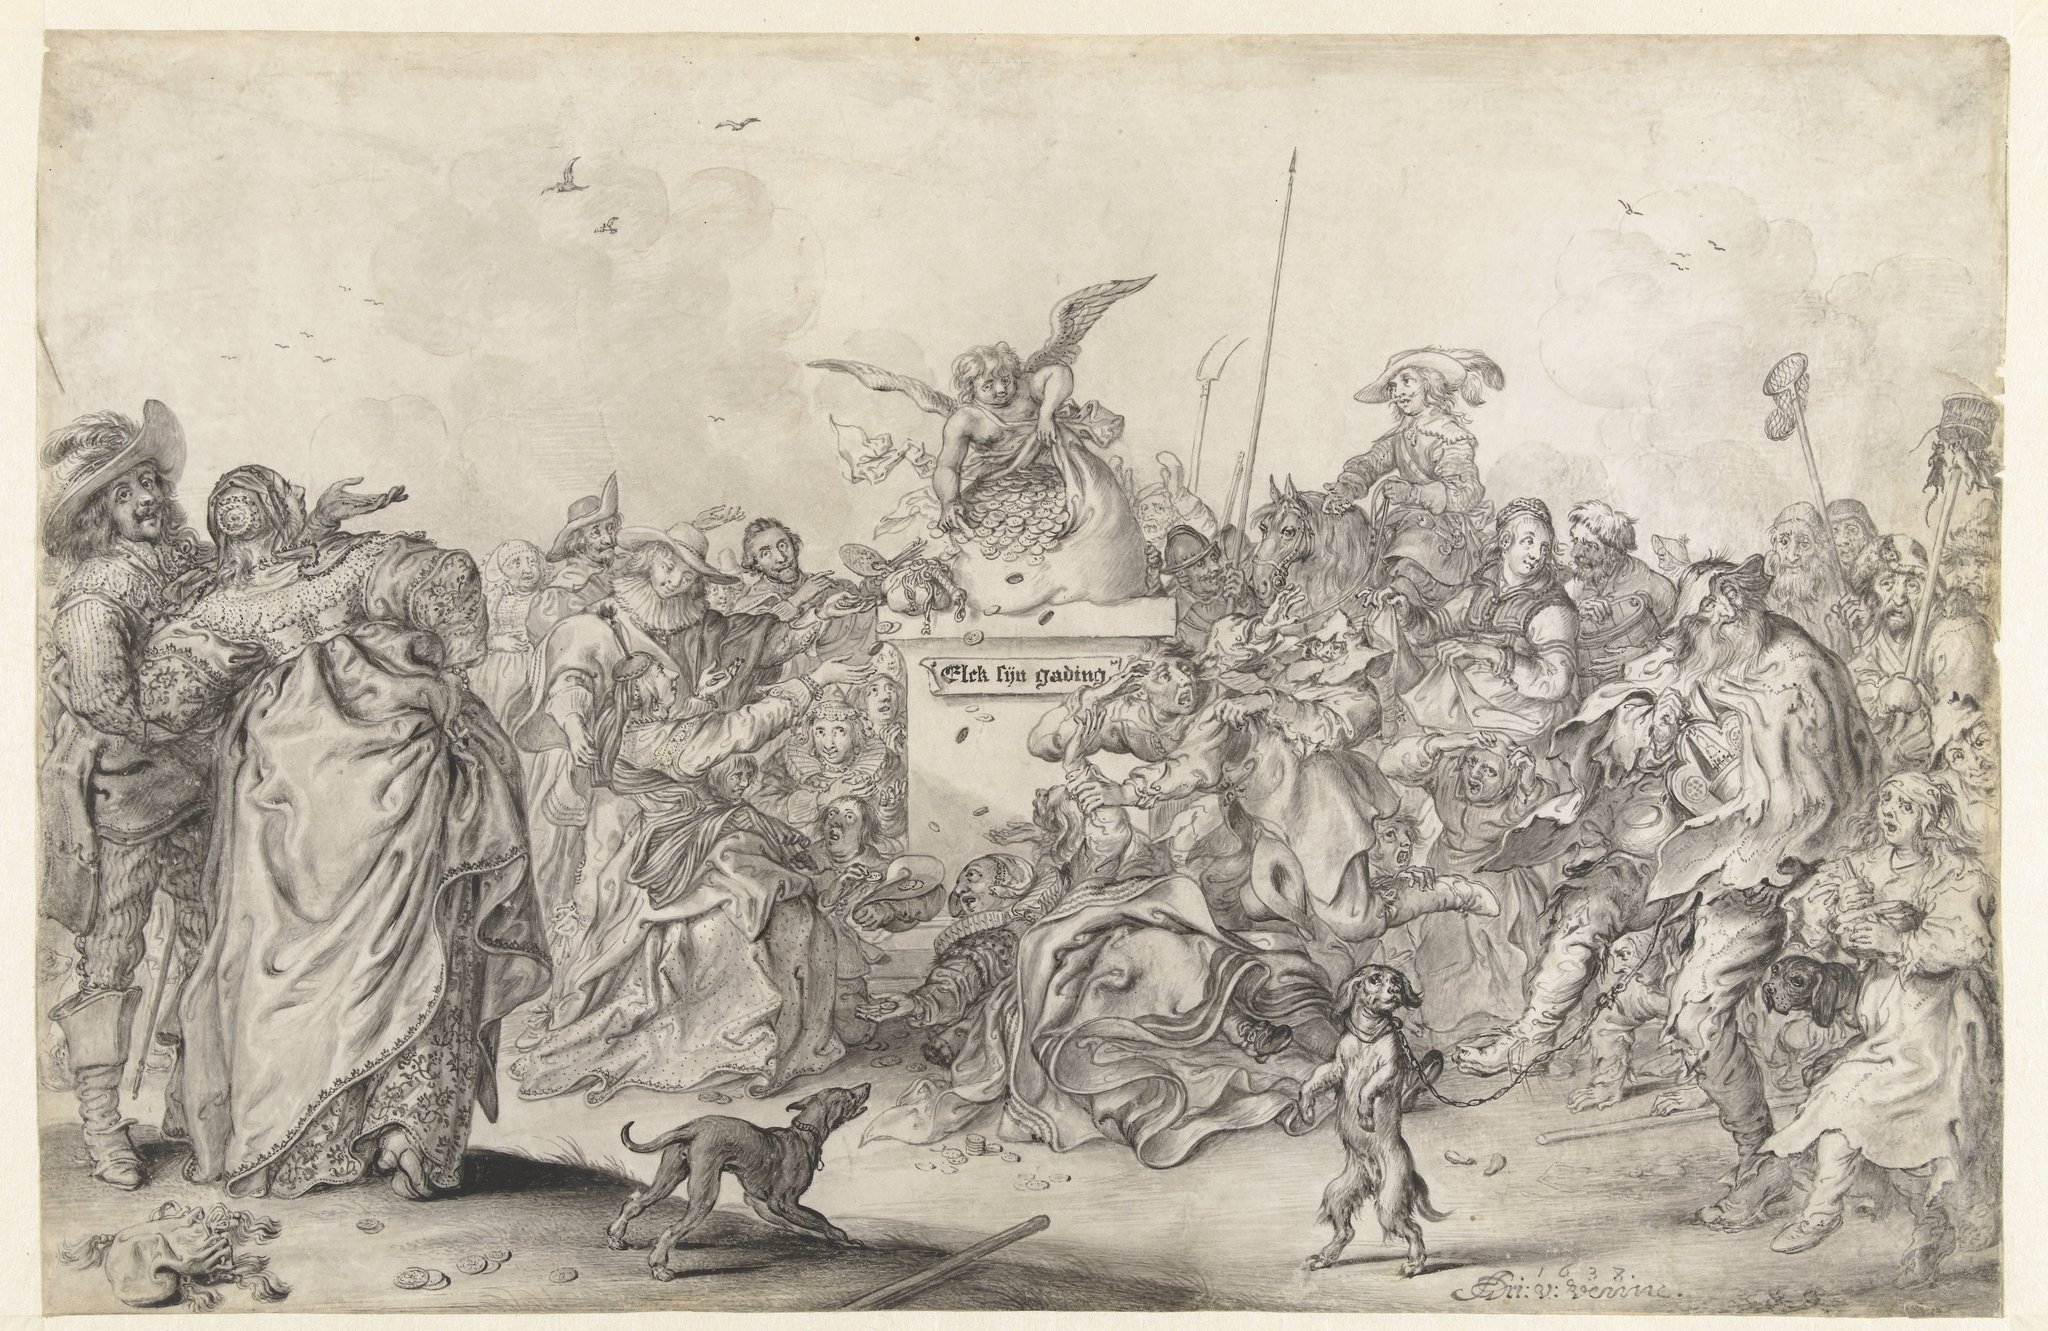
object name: drawing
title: ‘Something for Everyone’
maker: adriaen pietersz van de venne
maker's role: draughtsman, painter, print maker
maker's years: 1589-1662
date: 1638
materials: ink, parchment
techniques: brush, pen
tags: greed, covetousness, cupidity; 'cupidità' (ripa) (+ allegorical scene, i.e. two or more personifications involved in an action)